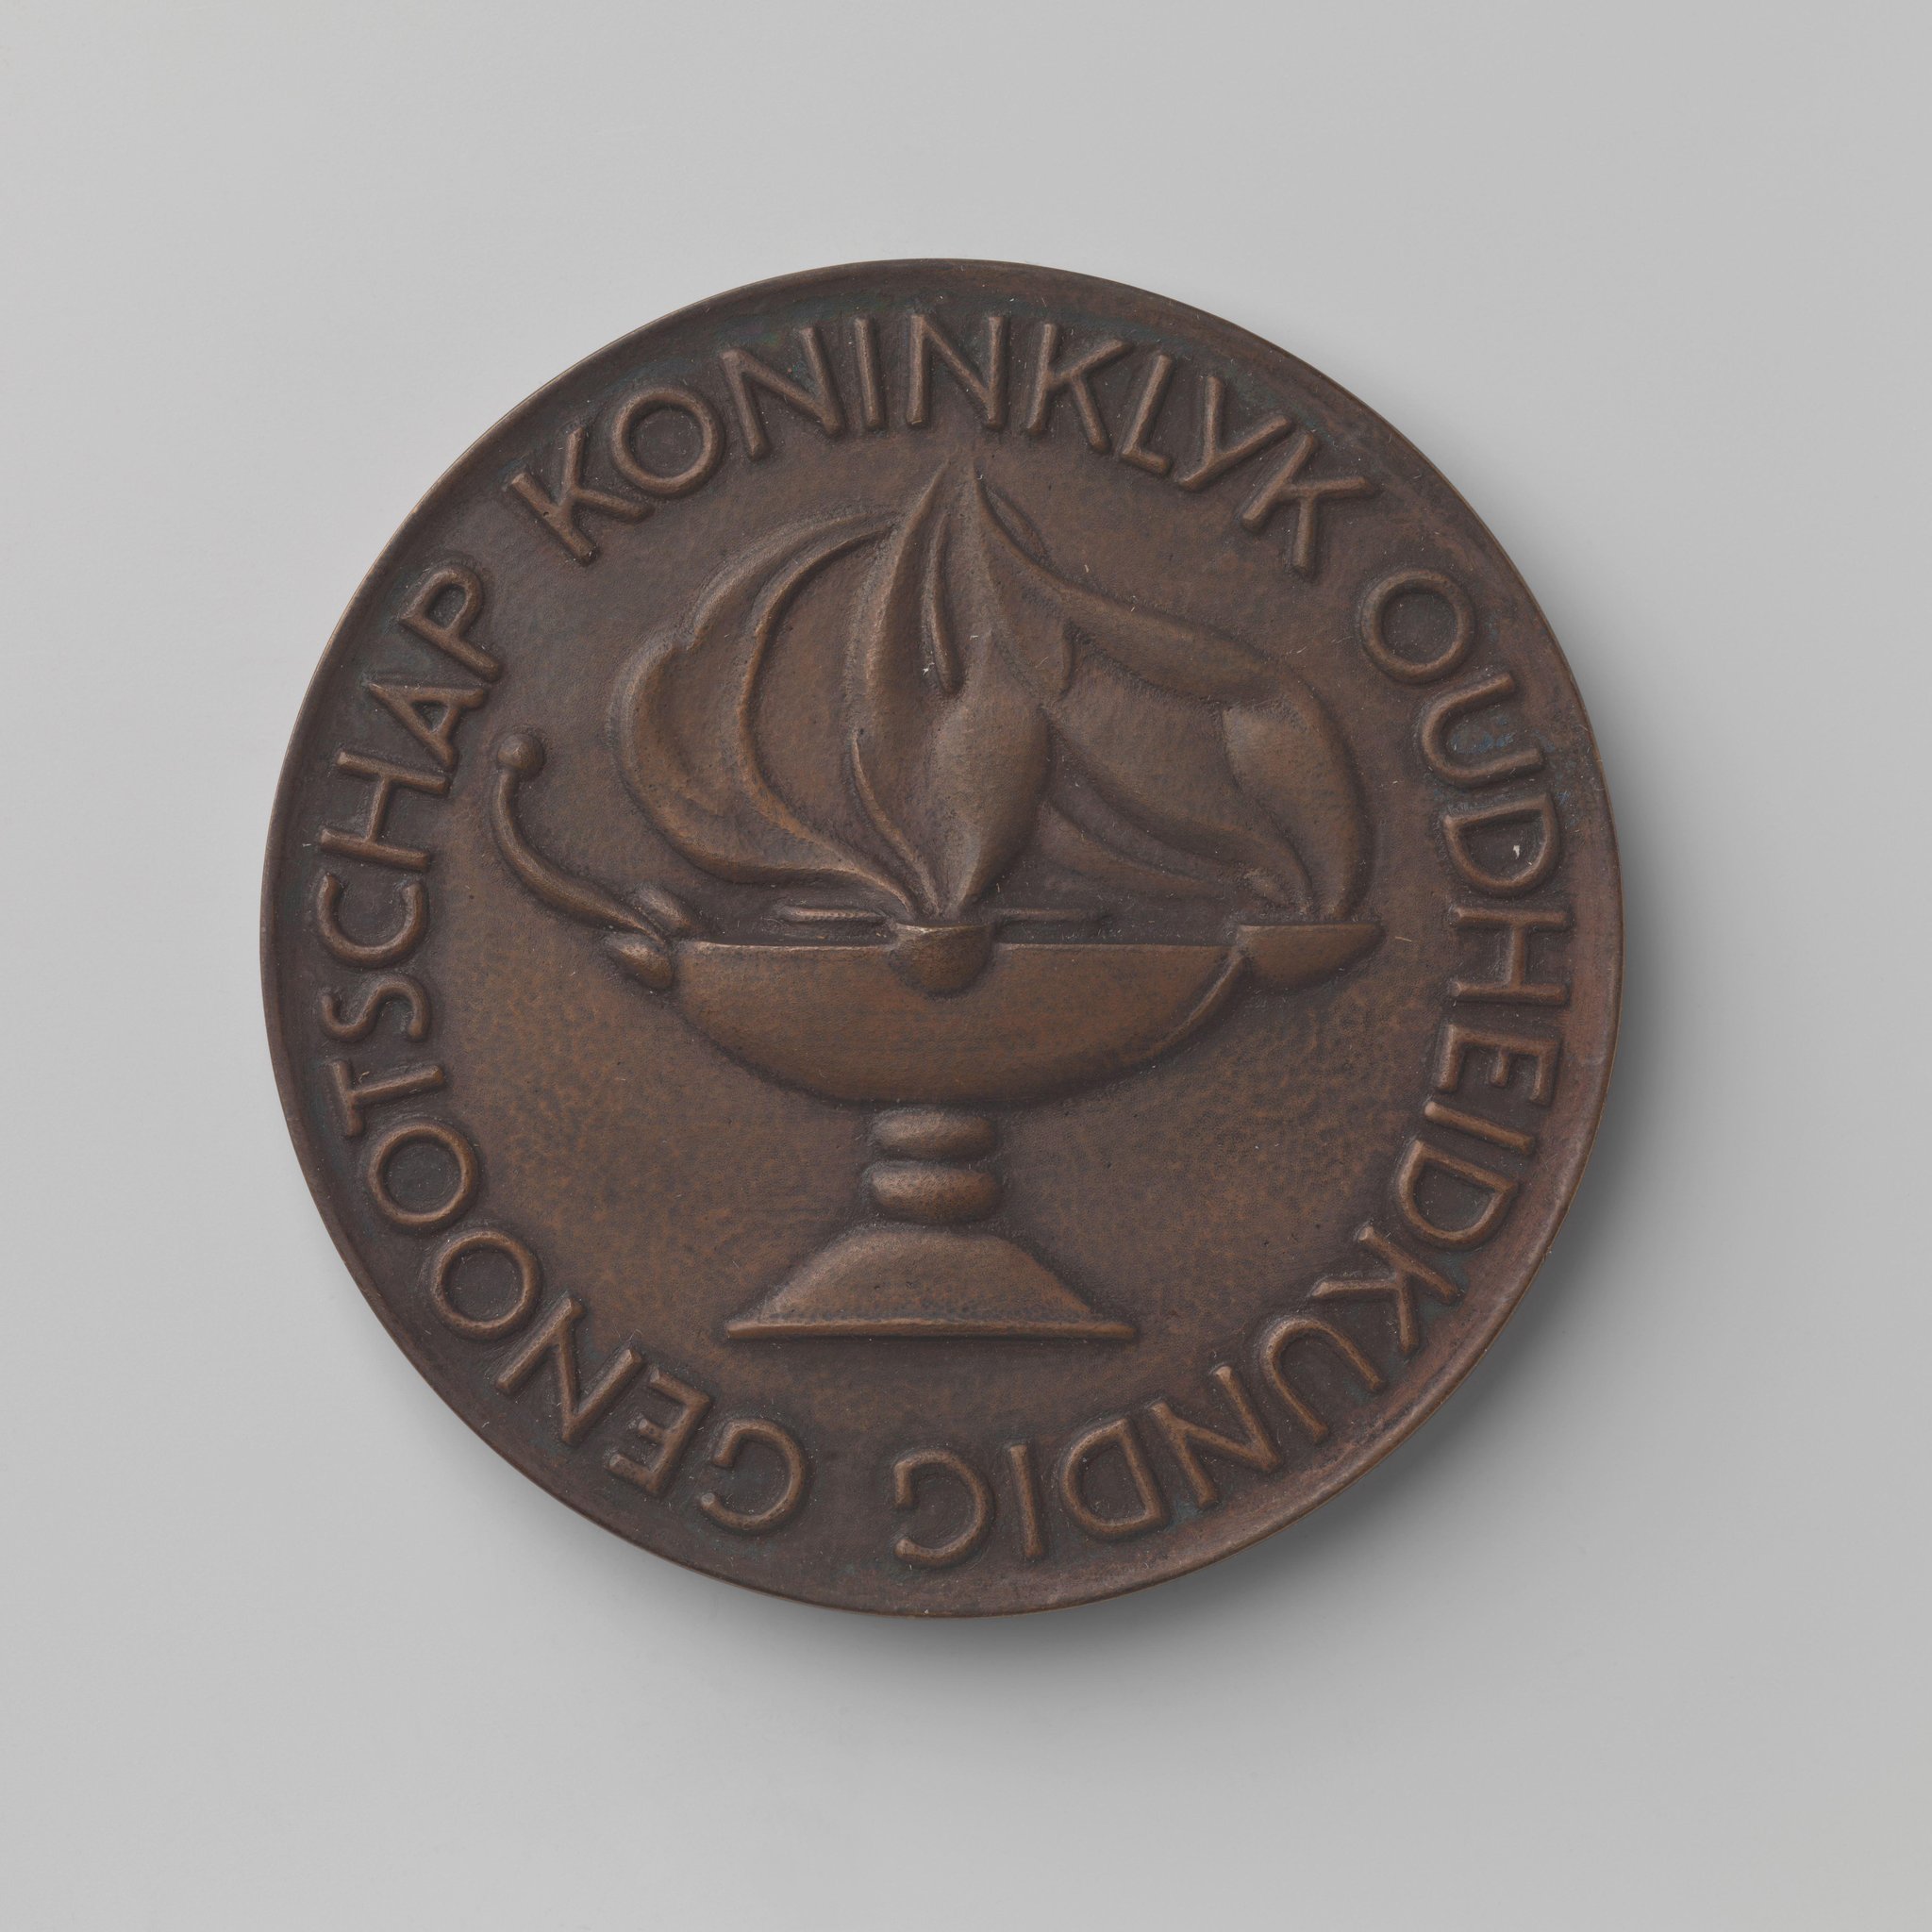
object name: history medal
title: Erepenning van het Koninklijk Oudheidkundig Genootschap te Amsterdam (1934)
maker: w. kloeke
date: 1934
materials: bronze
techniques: casting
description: Bronzen gegoten penning, op de voorzijde een brandende olielamp op voet met omschrift, de keerzijde blanco.